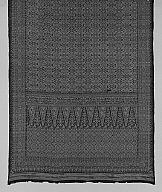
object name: sarong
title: Sarong (Kain Sudji)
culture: palembang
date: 1701-1800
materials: metal thread, silk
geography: indonesia